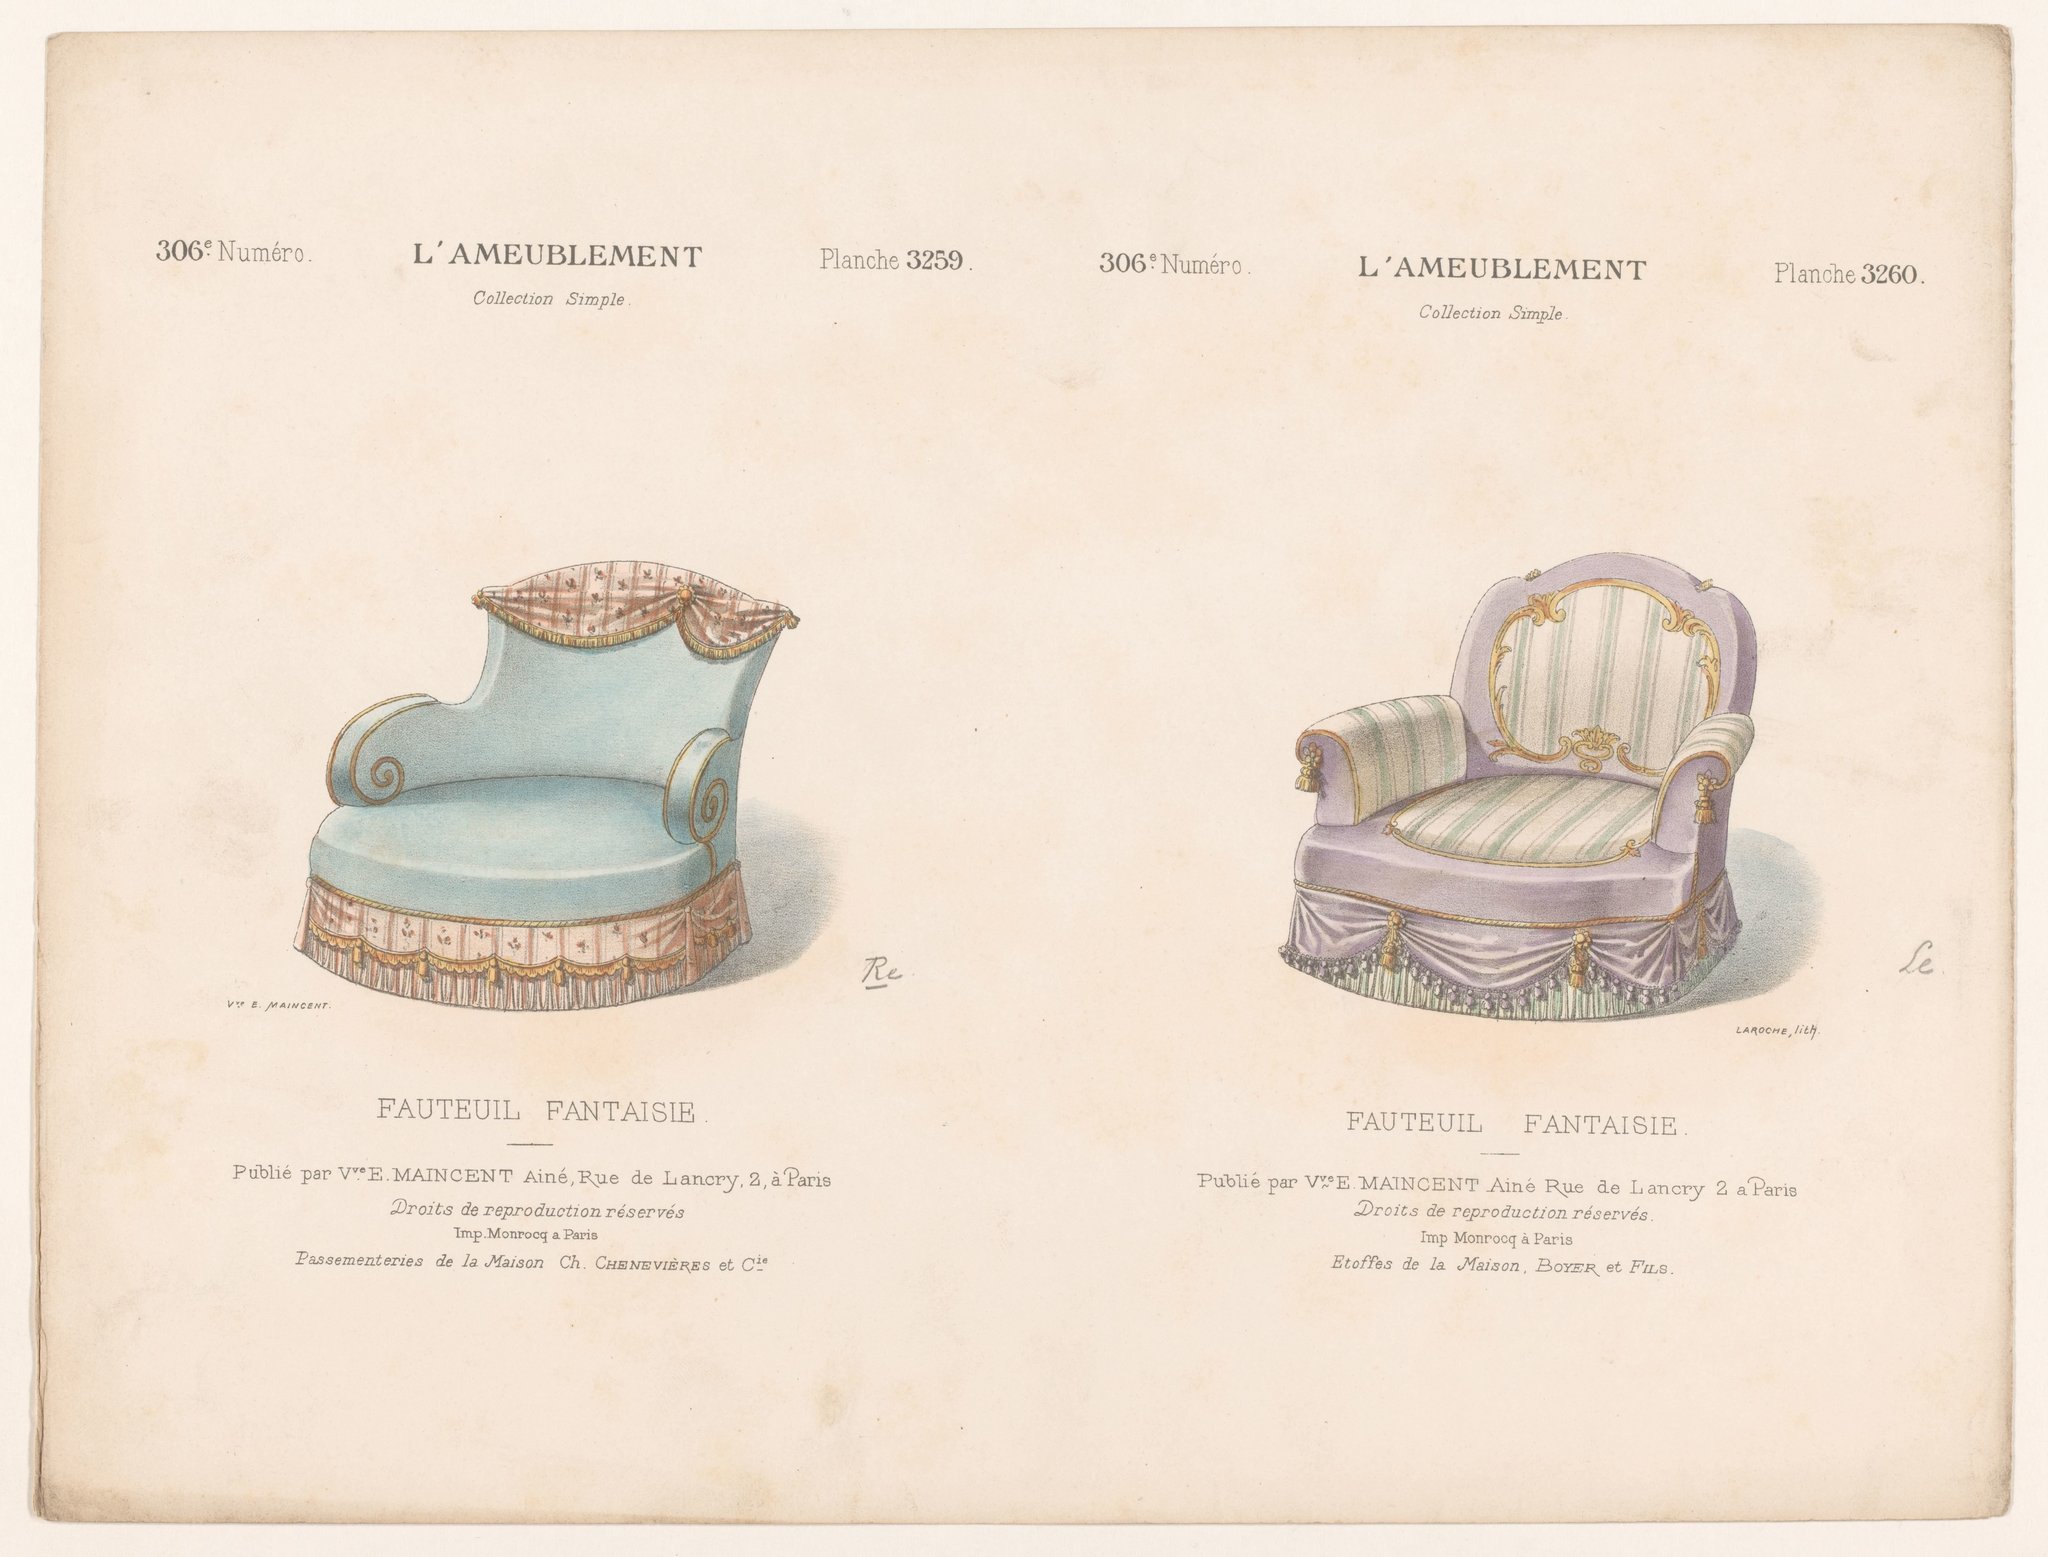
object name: print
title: Fauteuil fantaisie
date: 1895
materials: paper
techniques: hand coloring, lithograph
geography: paris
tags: seating furniture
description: Twee fauteuils. Prent uit 306e nummer (livraison).